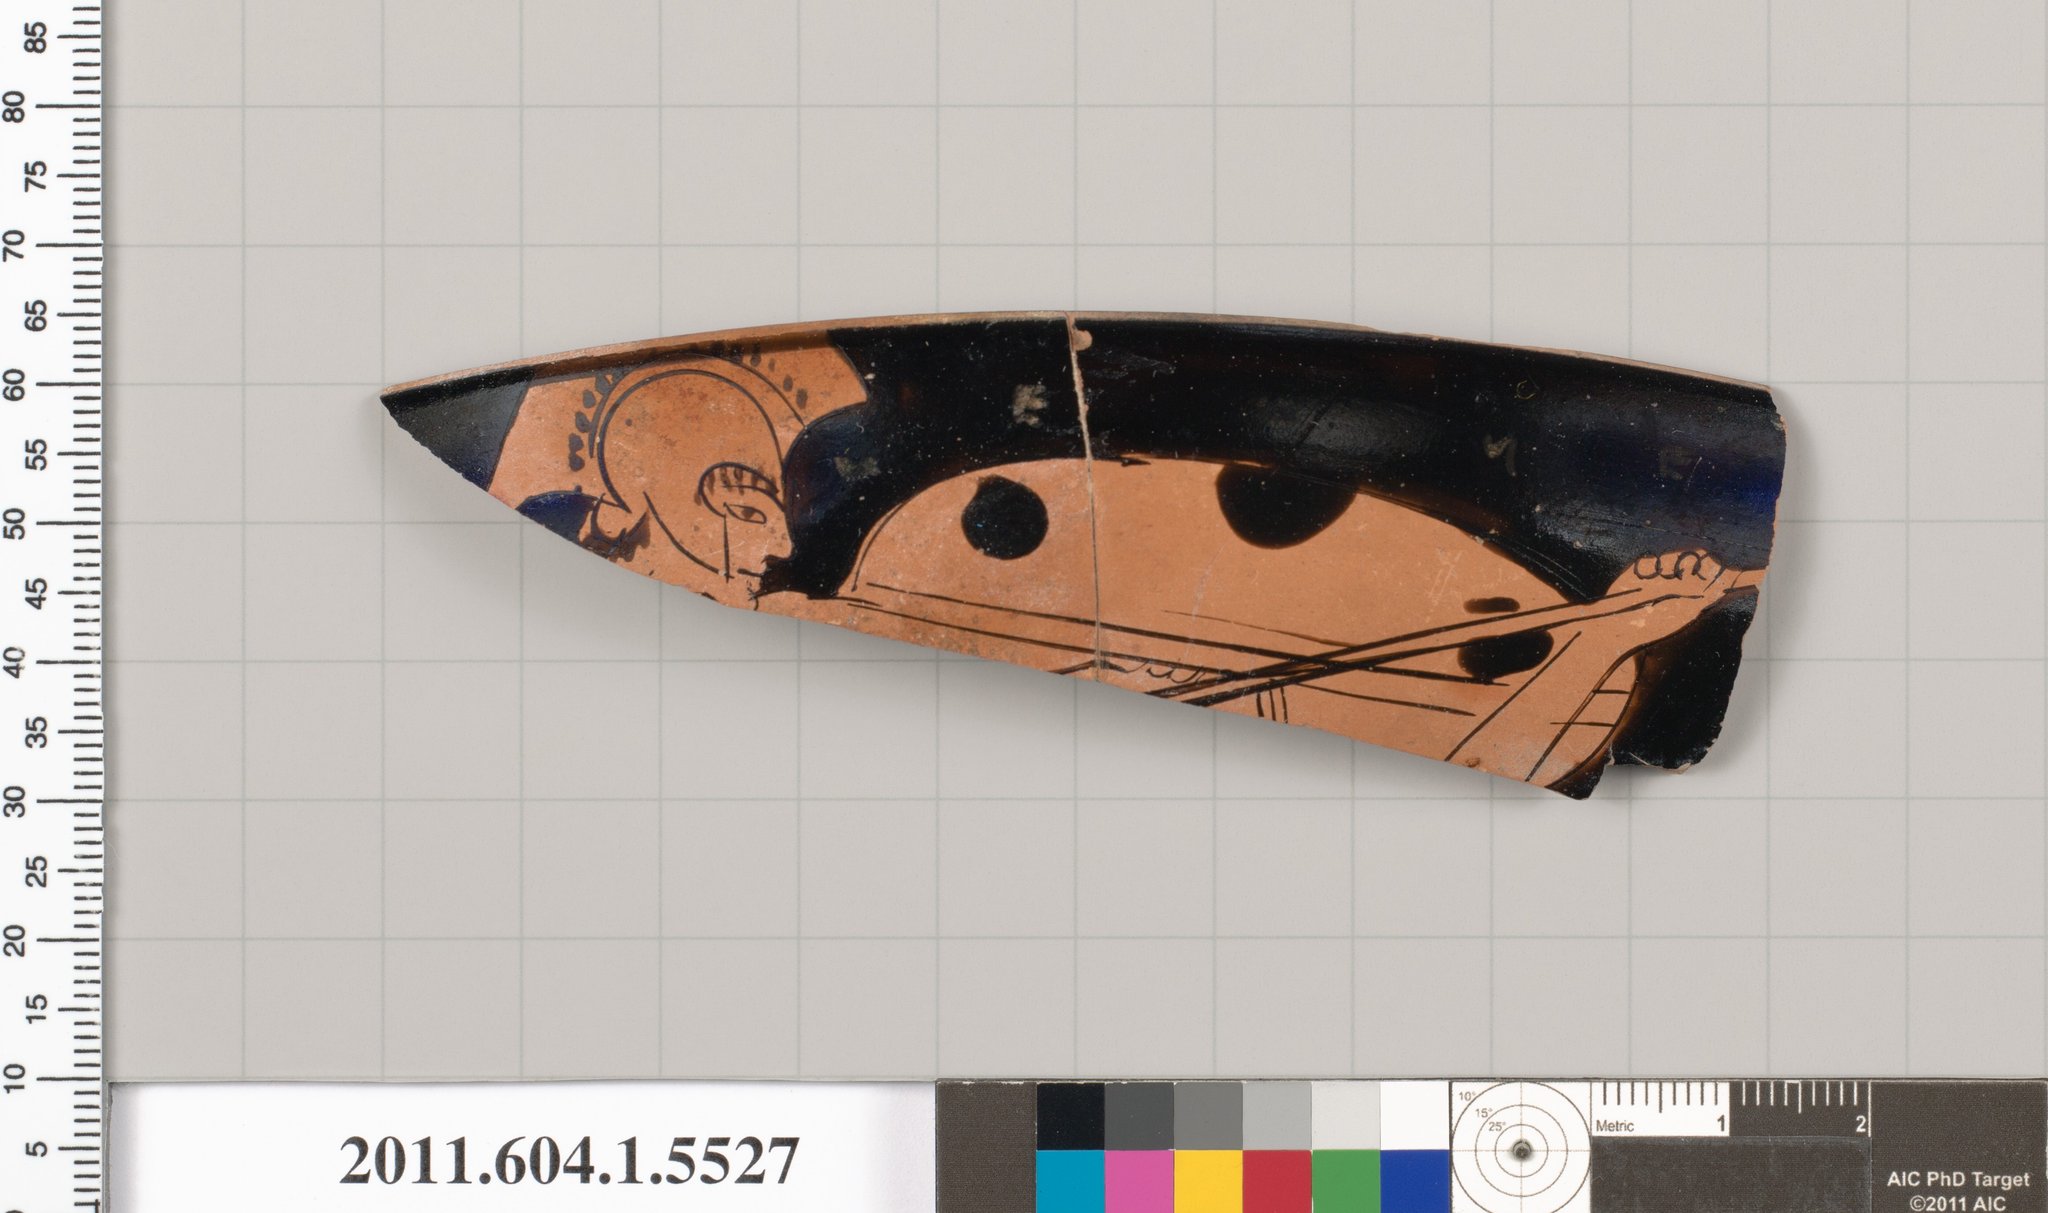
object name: kylix fragment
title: Terracotta rim fragment of a kylix (drinking cup)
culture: greek, attic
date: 520-510 BCE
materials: terracotta